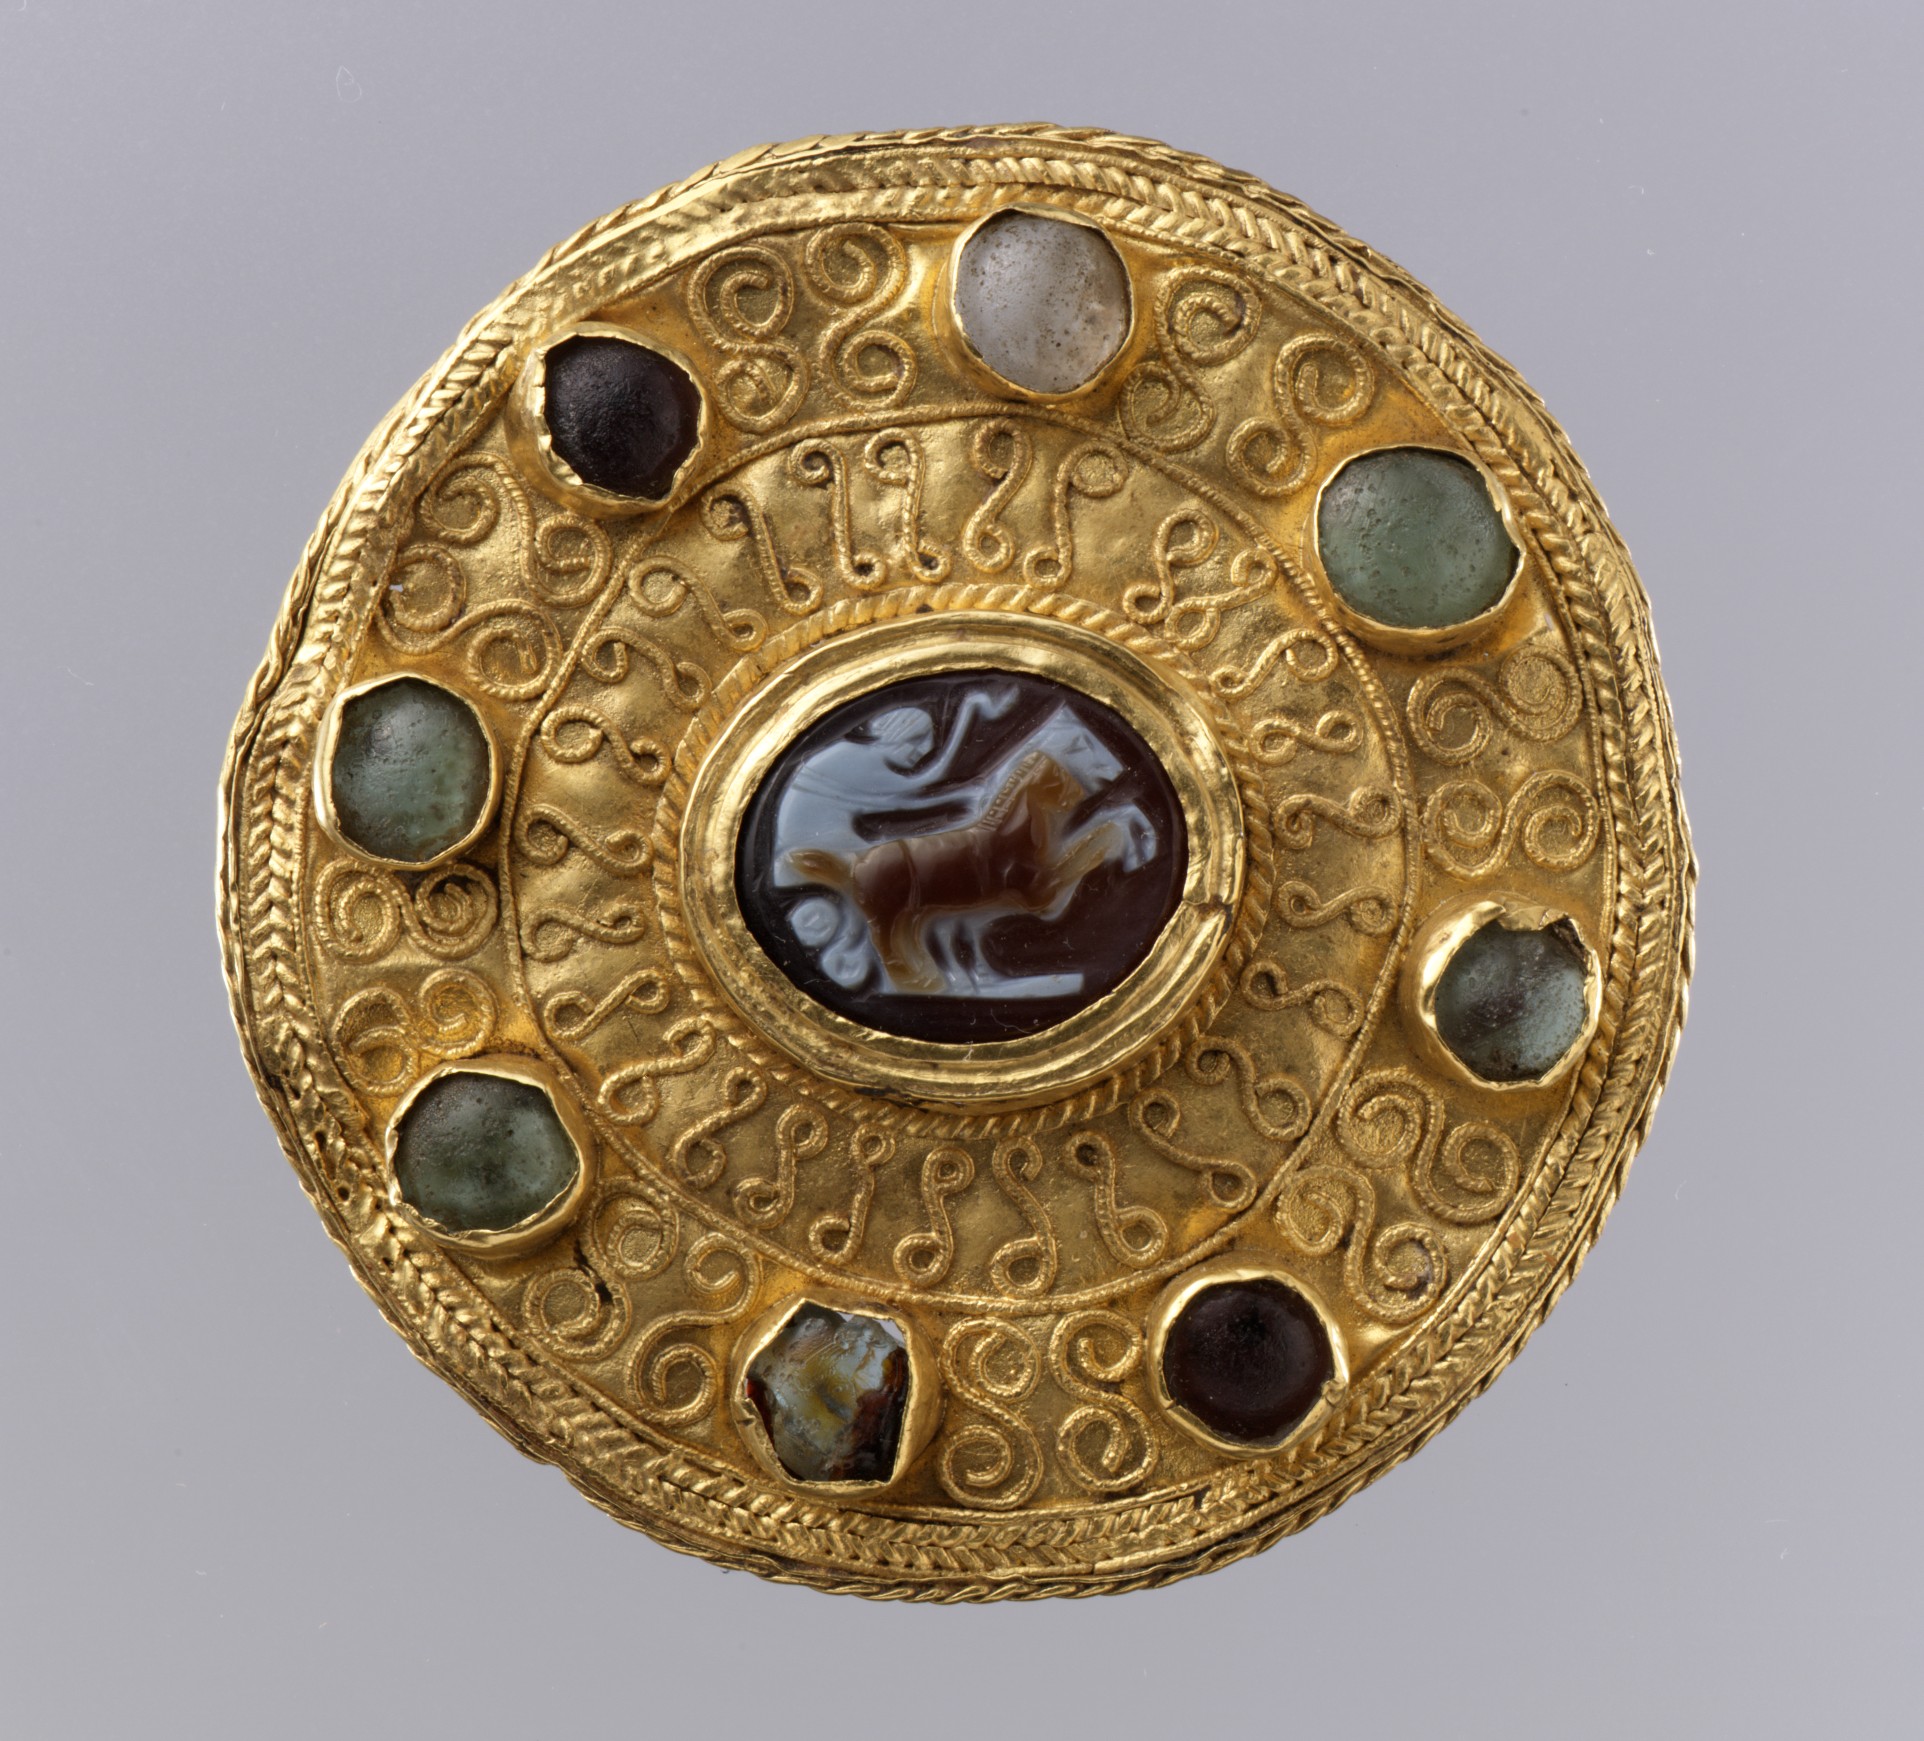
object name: disk brooch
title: Disk Brooch with Cameo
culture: langobardic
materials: glass, gold, onyx, metal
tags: women,horses,chariots